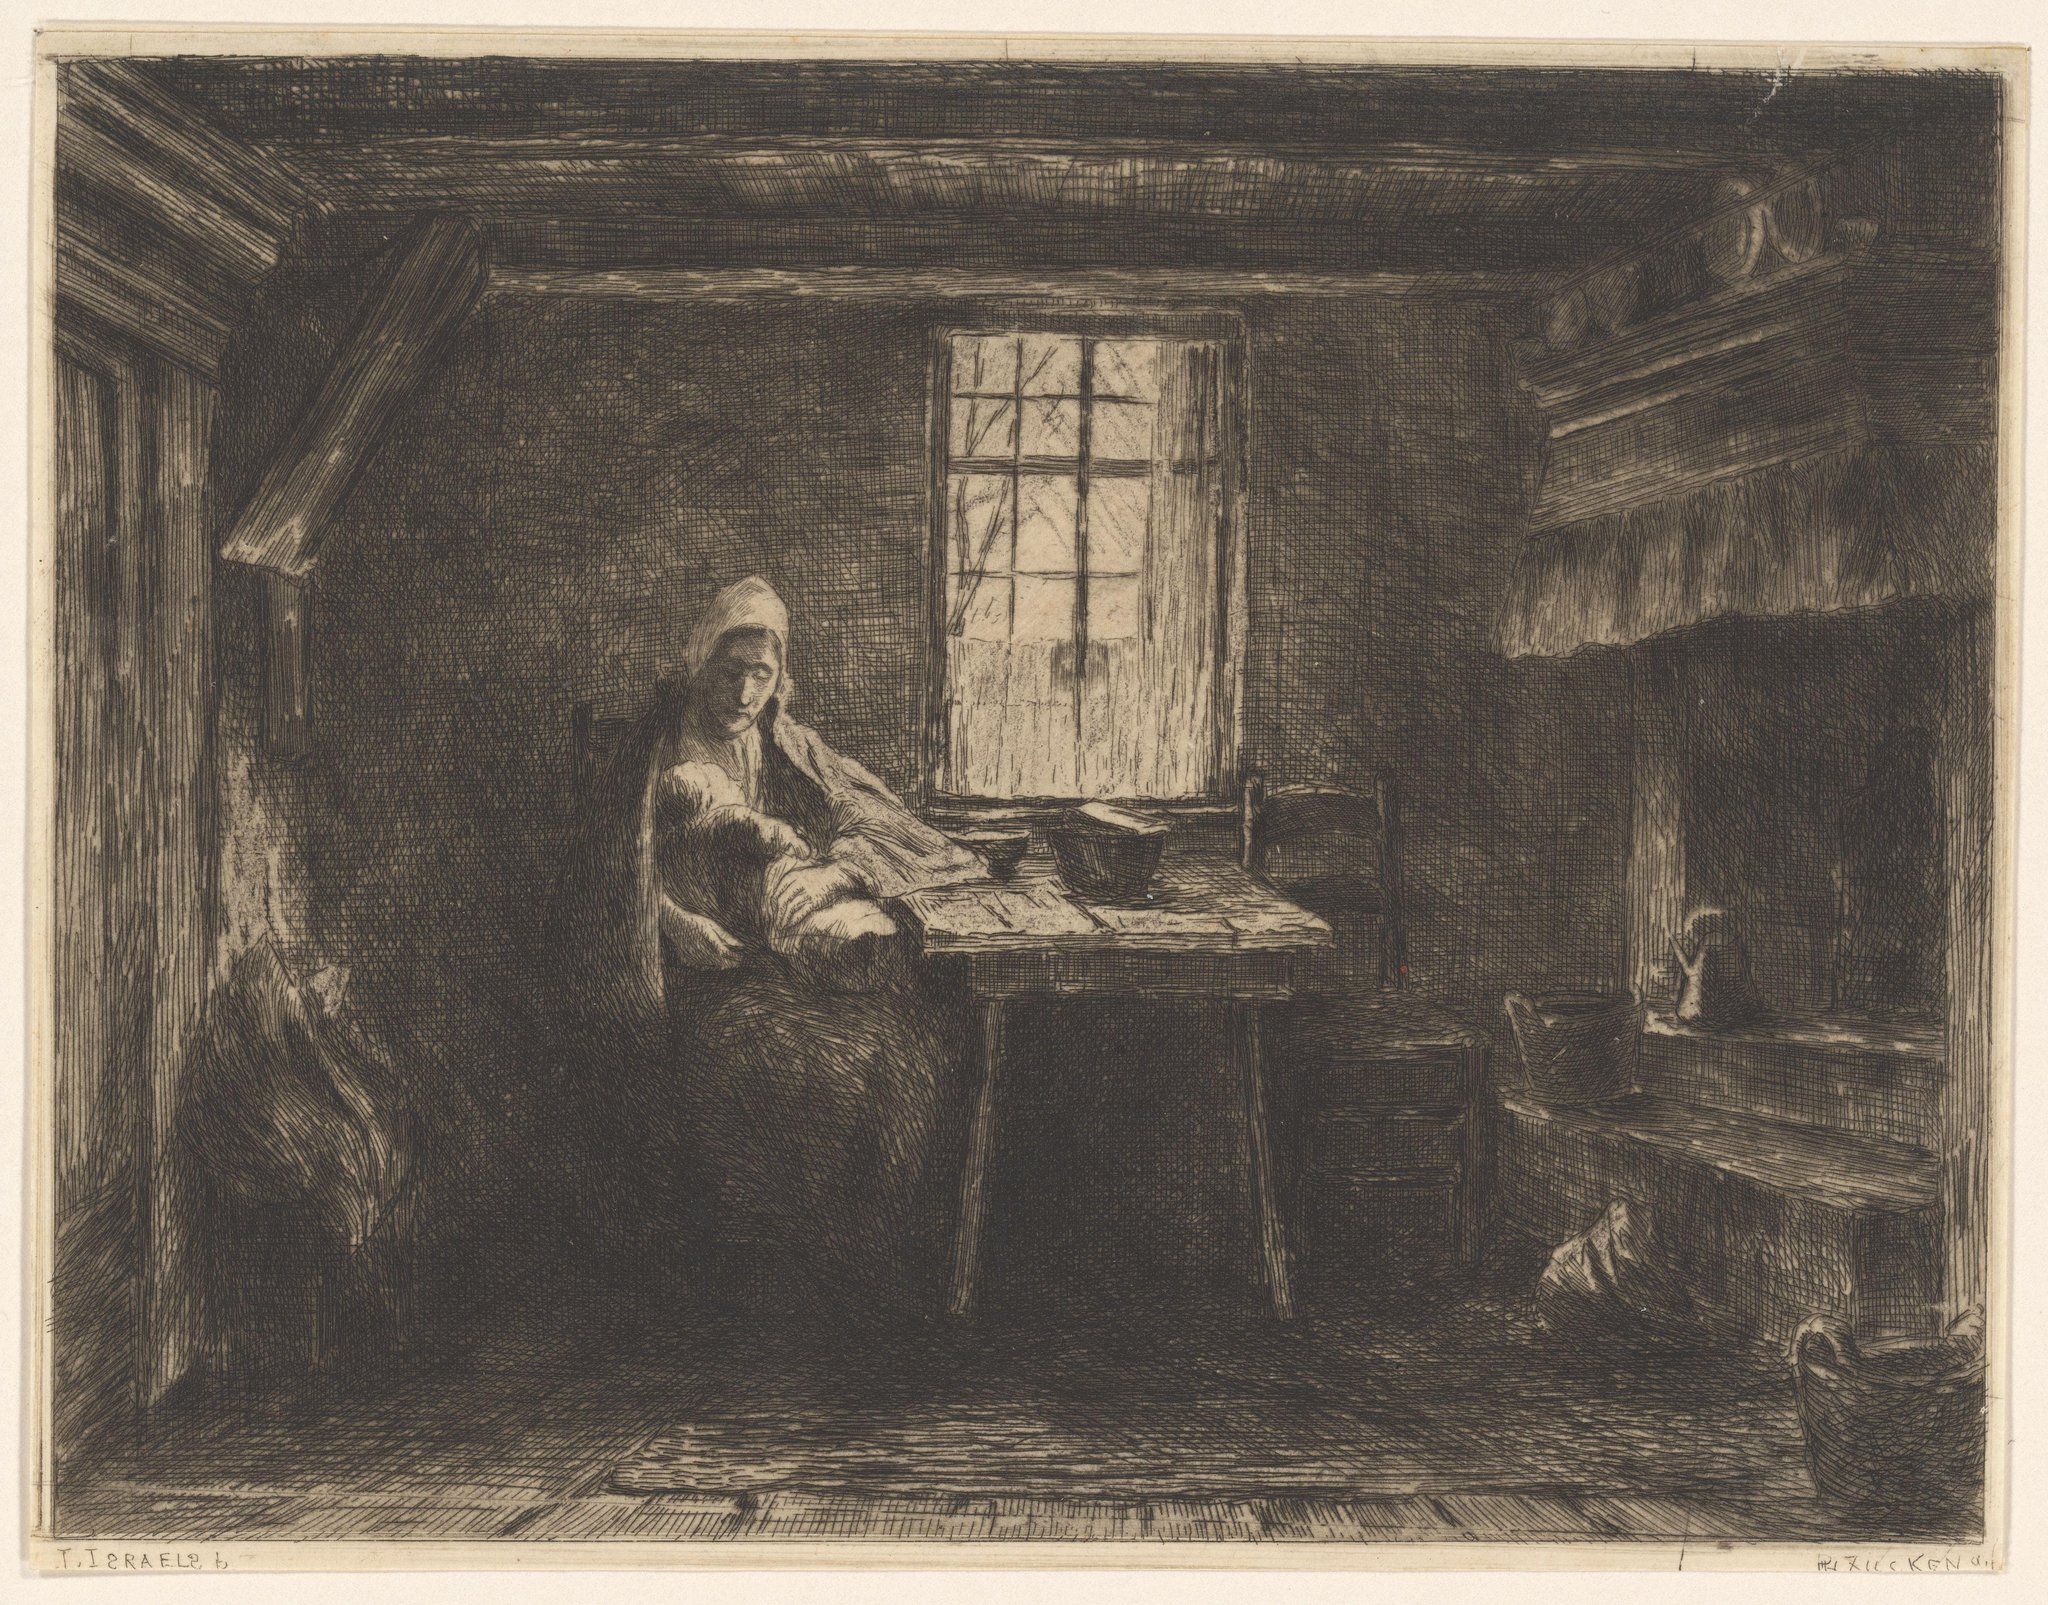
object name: print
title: Vrouw met slapend kind in een boereninterieur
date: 1888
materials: paper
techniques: etching, intaglio, soft ground etching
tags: mother and baby or young child, sleeping; unconsciousness, farm (building) - aa - civic architecture: inside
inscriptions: collector's mark: Lugt 2233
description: Prent is ook gebruikt in: Memorial catalogue of the French and Dutch. Edinburgh: David Douglas, 1888.